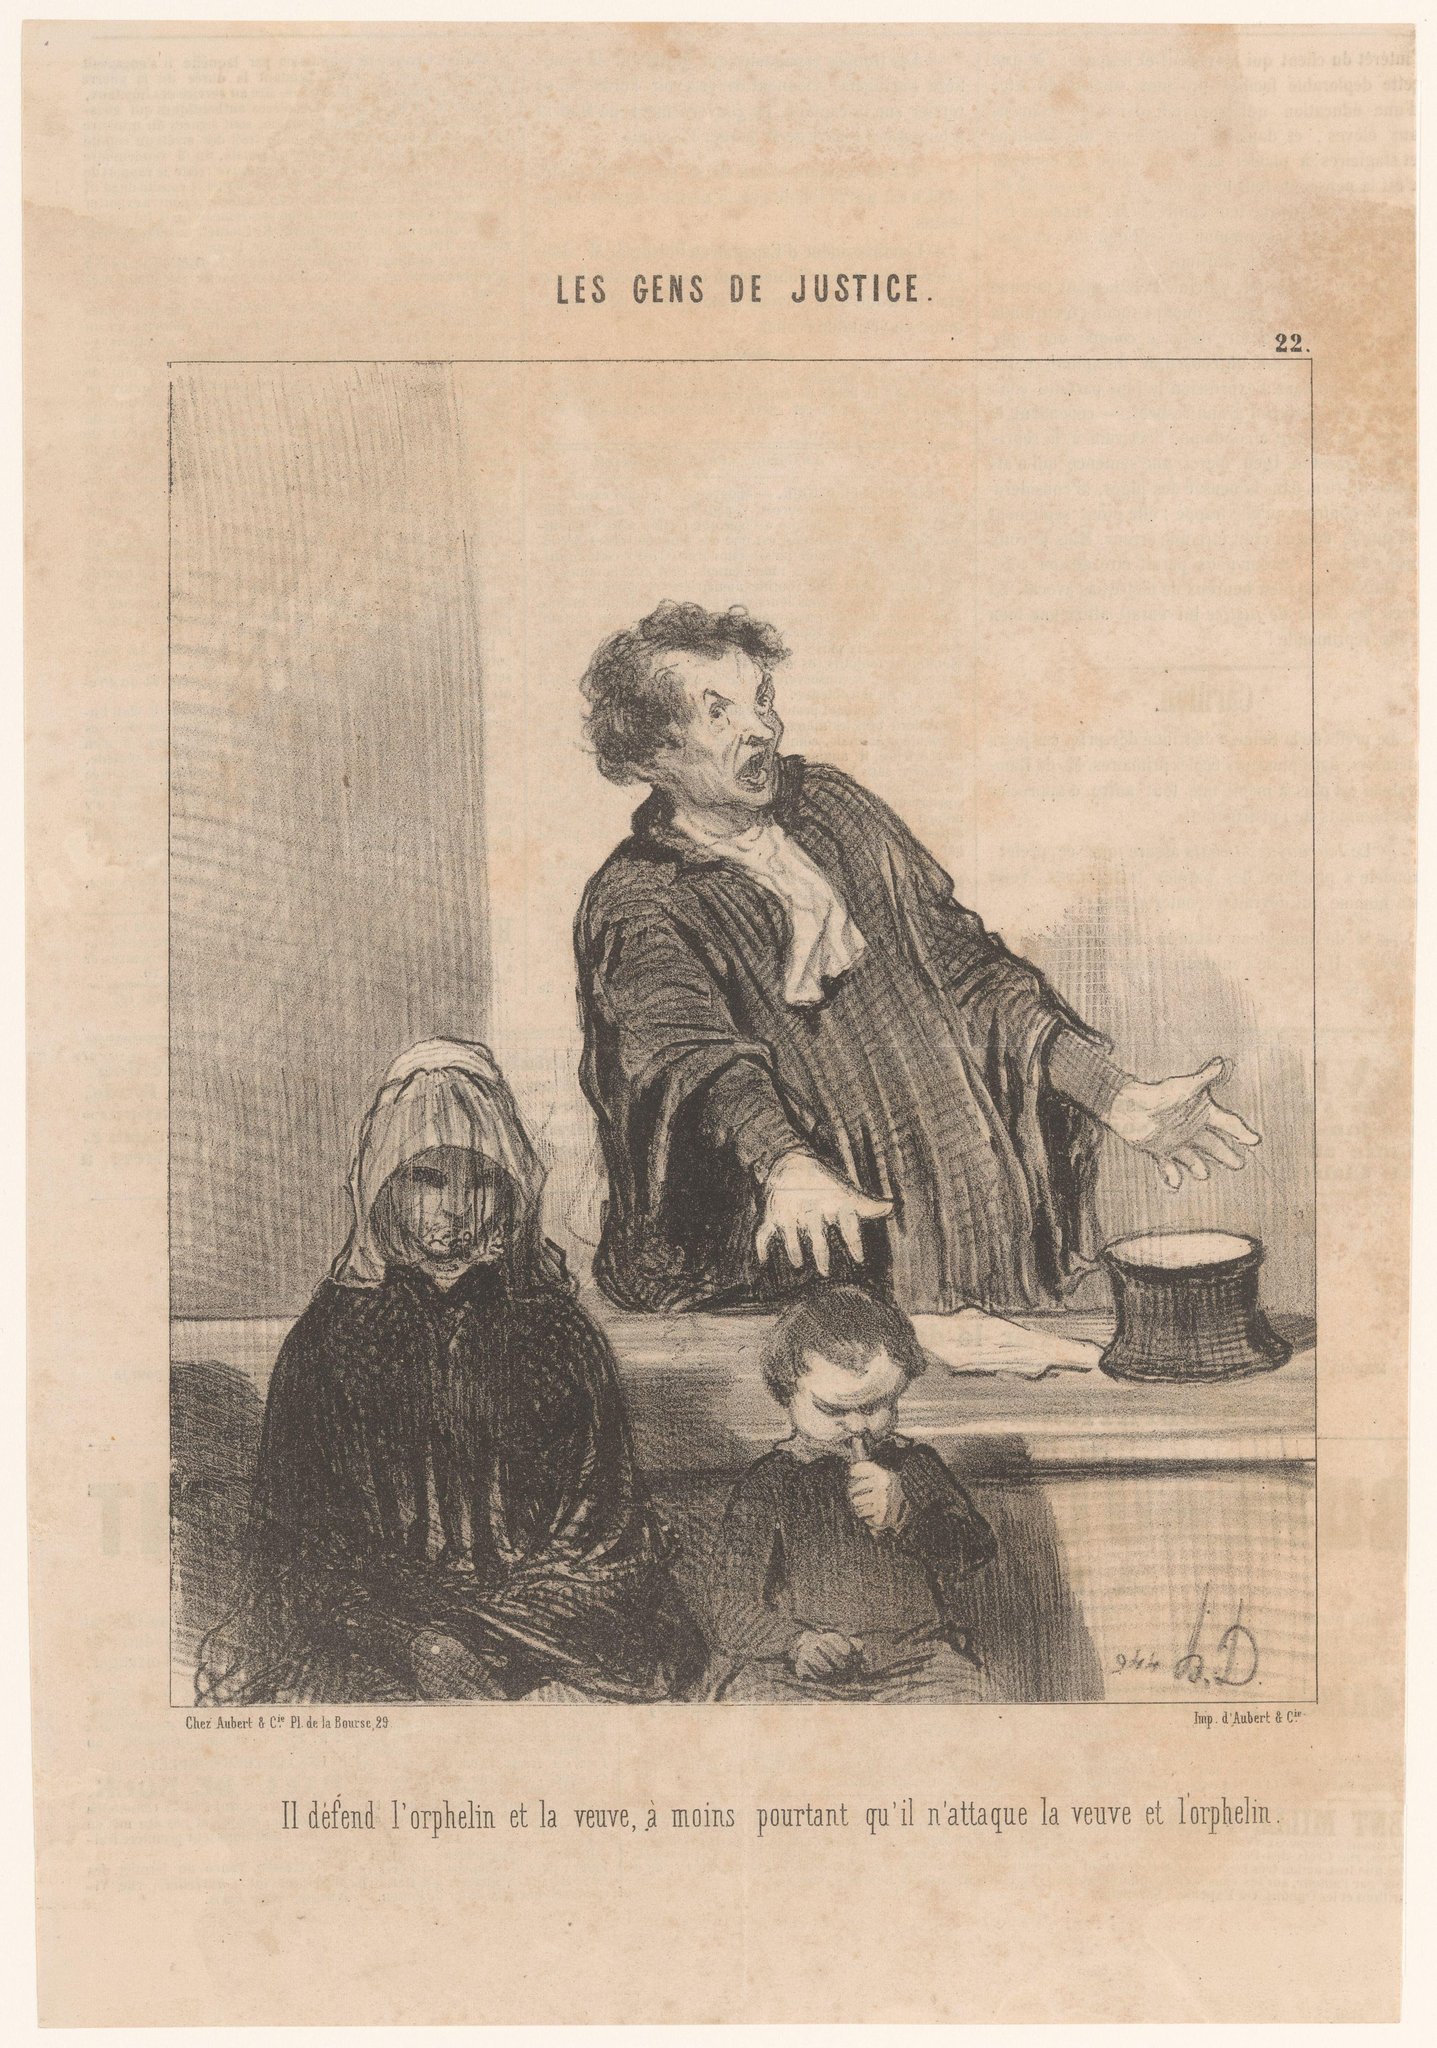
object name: cartoon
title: Les gens de justice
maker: honoré daumier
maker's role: draughtsman, painter, print maker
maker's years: 1808-1879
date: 1846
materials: paper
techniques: lithograph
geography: paris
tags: the accused, plea, defence, caricatures (human types), widow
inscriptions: collector's mark: Lugt 2228a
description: De advocaat verdedigt de weduwe en de wees in de zin van: hij beschuldigt hen niet.